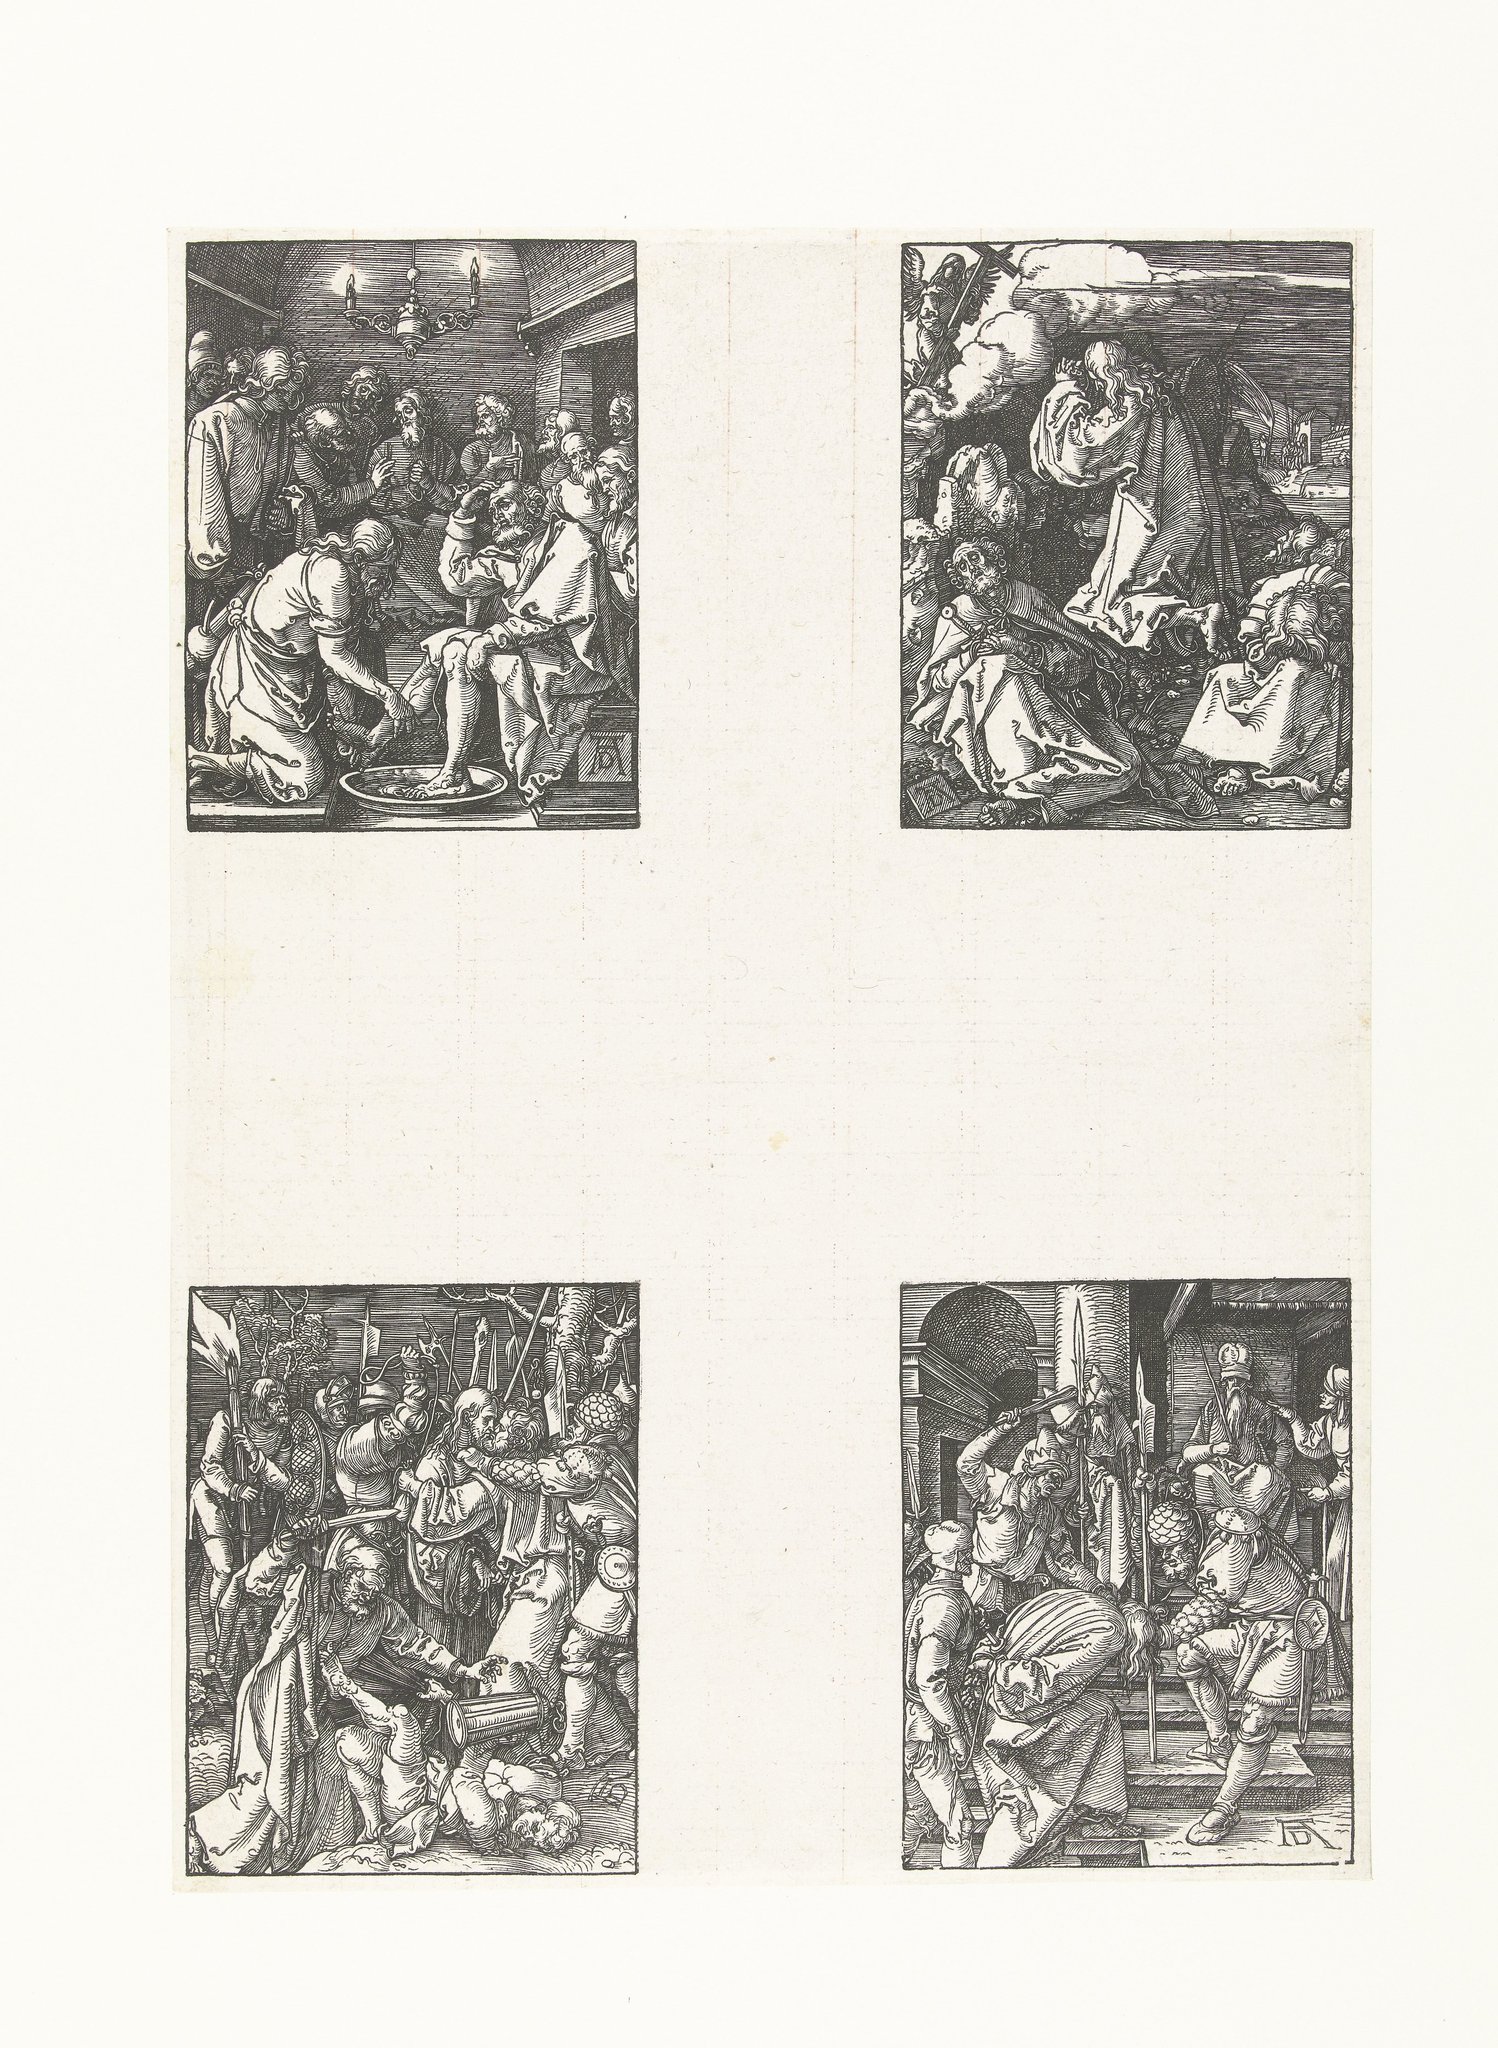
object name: print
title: De kleine Passie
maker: albrecht dürer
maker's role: draughtsman, painter, print maker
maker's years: 1471-1528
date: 1508-1510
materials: paper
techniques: woodcut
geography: nuremberg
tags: the kiss of judas: accompanied by soldiers with torches and lanterns, he kisses christ, christ washes peter's feet, christ's prayer in the garden of gethsemane during the night, christ before annas (hanna); maybe a soldier about to strike christ (john 18:13, 18:19-24)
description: De derde reeks van vier scènes uit de prentserie 'De kleine Passie', hier nog onversneden met 4 afbeeldingen op 1 blad. Linksboven: Christus wast de voeten van de discipel Petrus. Rechtsboven: Christus bidt in de Hof van Getsemane, terwijl zijn discipelen om hem heen liggen te slapen. Linksonder: Christus wordt door Judas met een kus verraden en door soldaten gevangen genomen. Rechtsonder: Christus wordt door gewapende mannen voor Annas geleid.